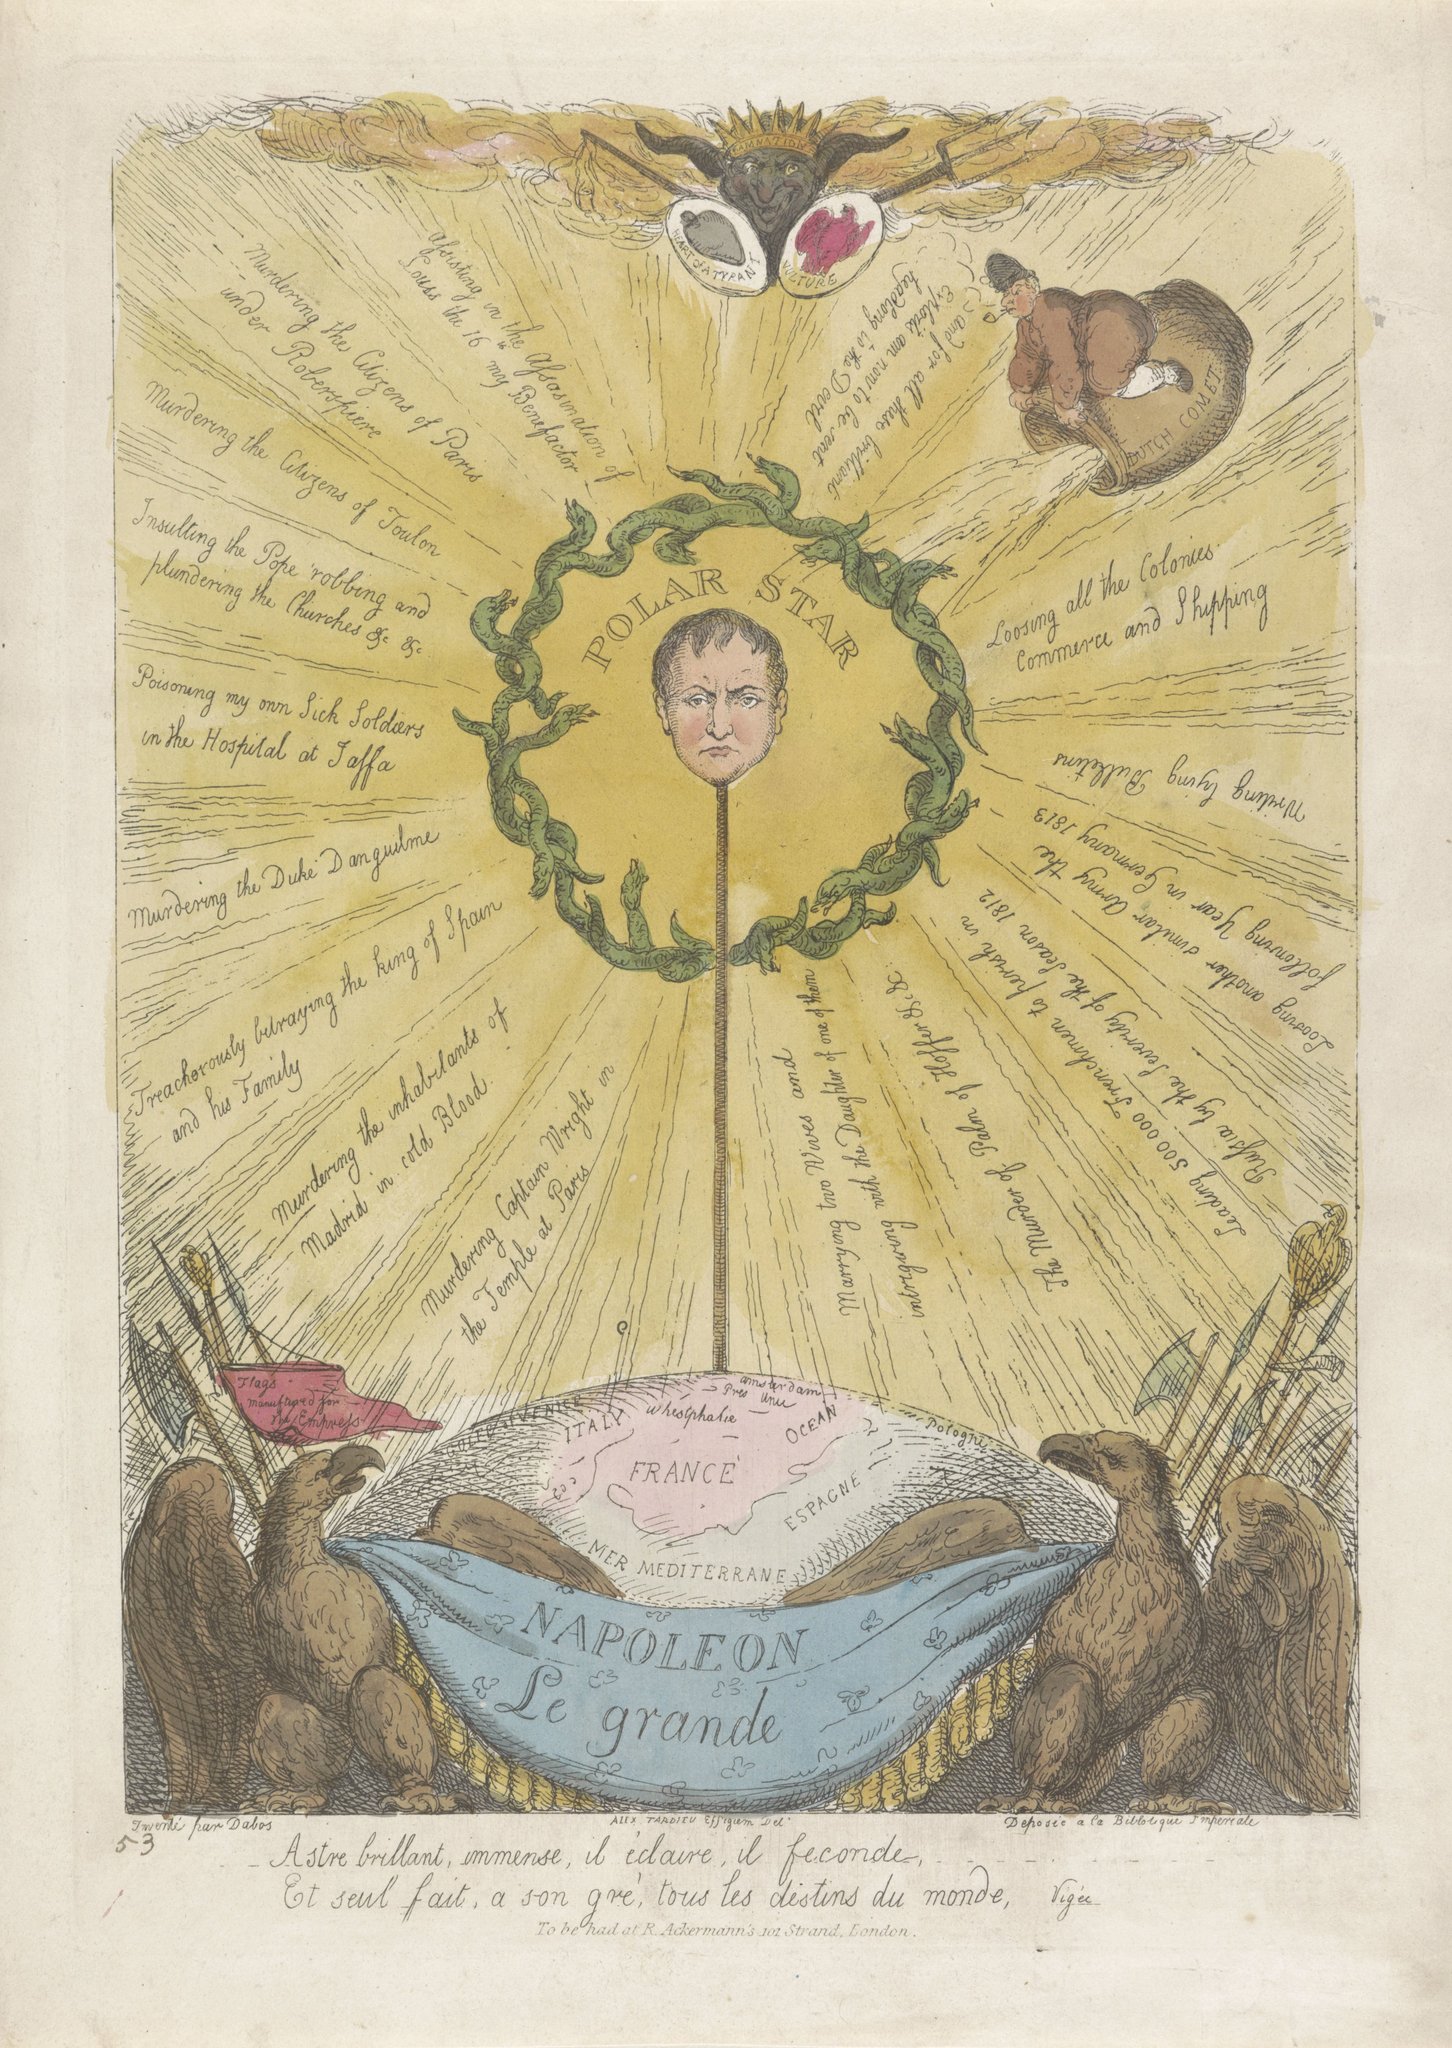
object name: cartoon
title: Spotprent met Napoleon als de poolster, 1813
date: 1813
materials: paper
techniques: etching, hand coloring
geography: france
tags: napoleon i (emperor of the french), stars and constellations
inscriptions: collector's mark: Lugt 2228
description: Spotprent op Napoleon als de stralende poolster. Het hoofd van Napoleon binnen een krans van slangen prijkt stralend als de poolster op een stok boven de wereldbol. In de stralen opschriften met alle wandaden van de keizer. Onderaan twee adelaars met een doek, bovenaan de duivel, rechtsboven spuit een zittende dikke Hollander op een kruik genaamd 'Dutch Comet' een vloeistof richting Napoleon in een poging zijn glans te blussen. Met tweeregelig Frans onderschrift. Satirische kopie naar een Frans voorbeeld 'Astre brillant'.